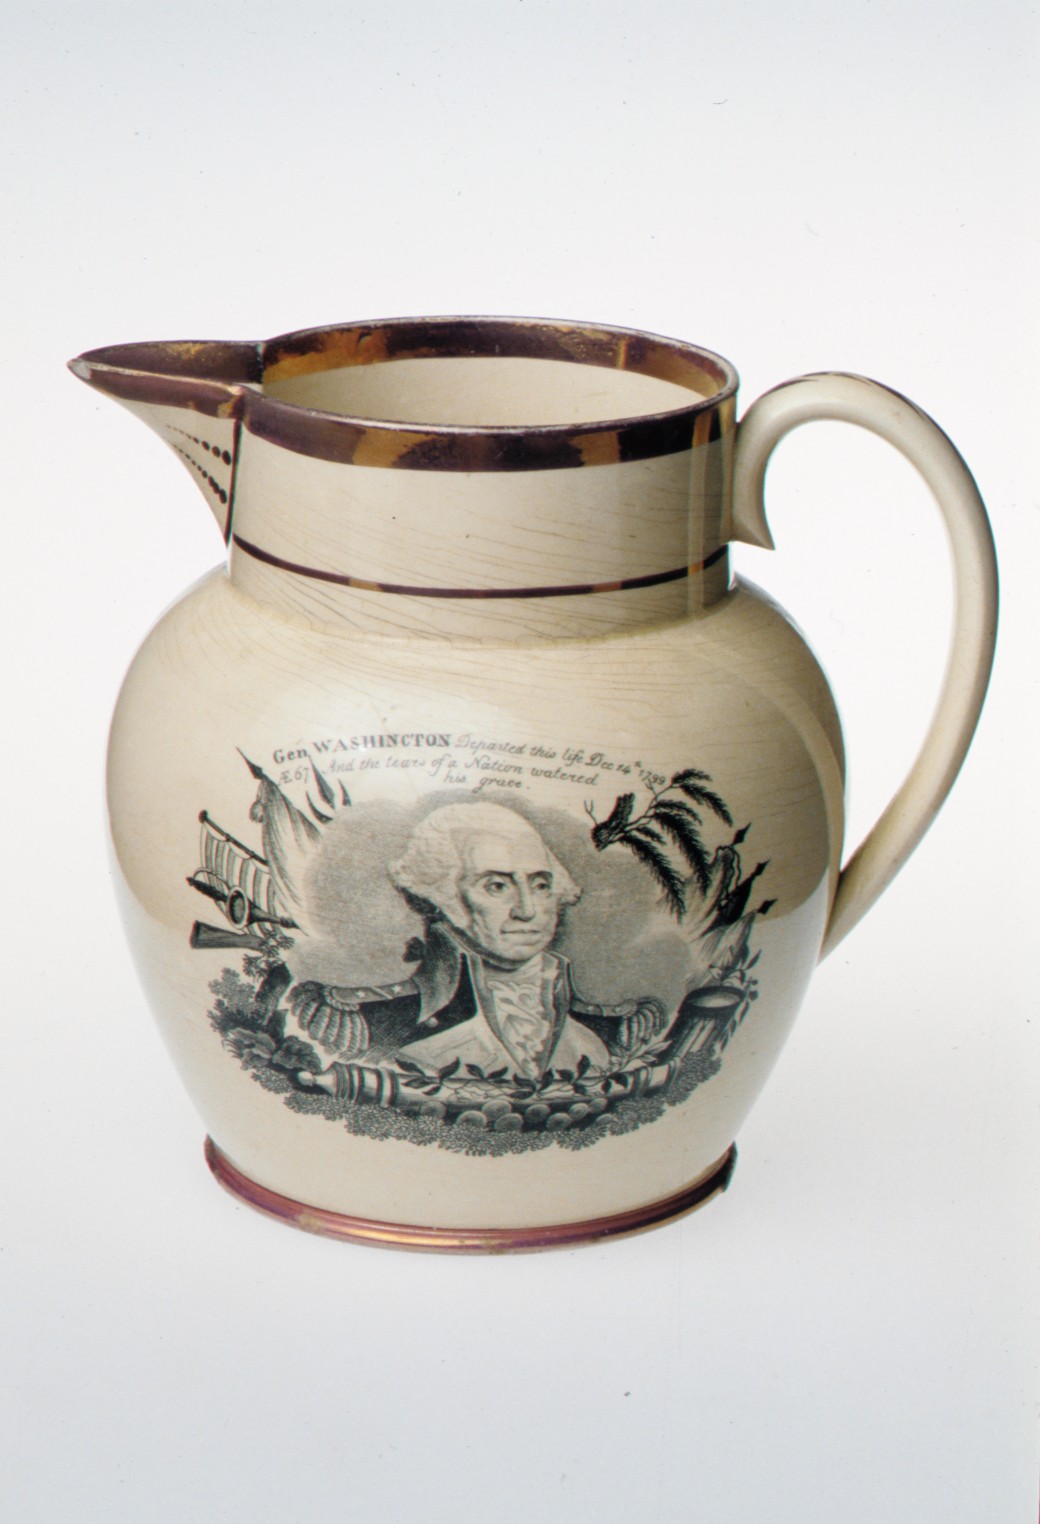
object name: pitcher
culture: british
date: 1813-1815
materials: earthenware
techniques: transfer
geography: england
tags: george washington,men,portraits